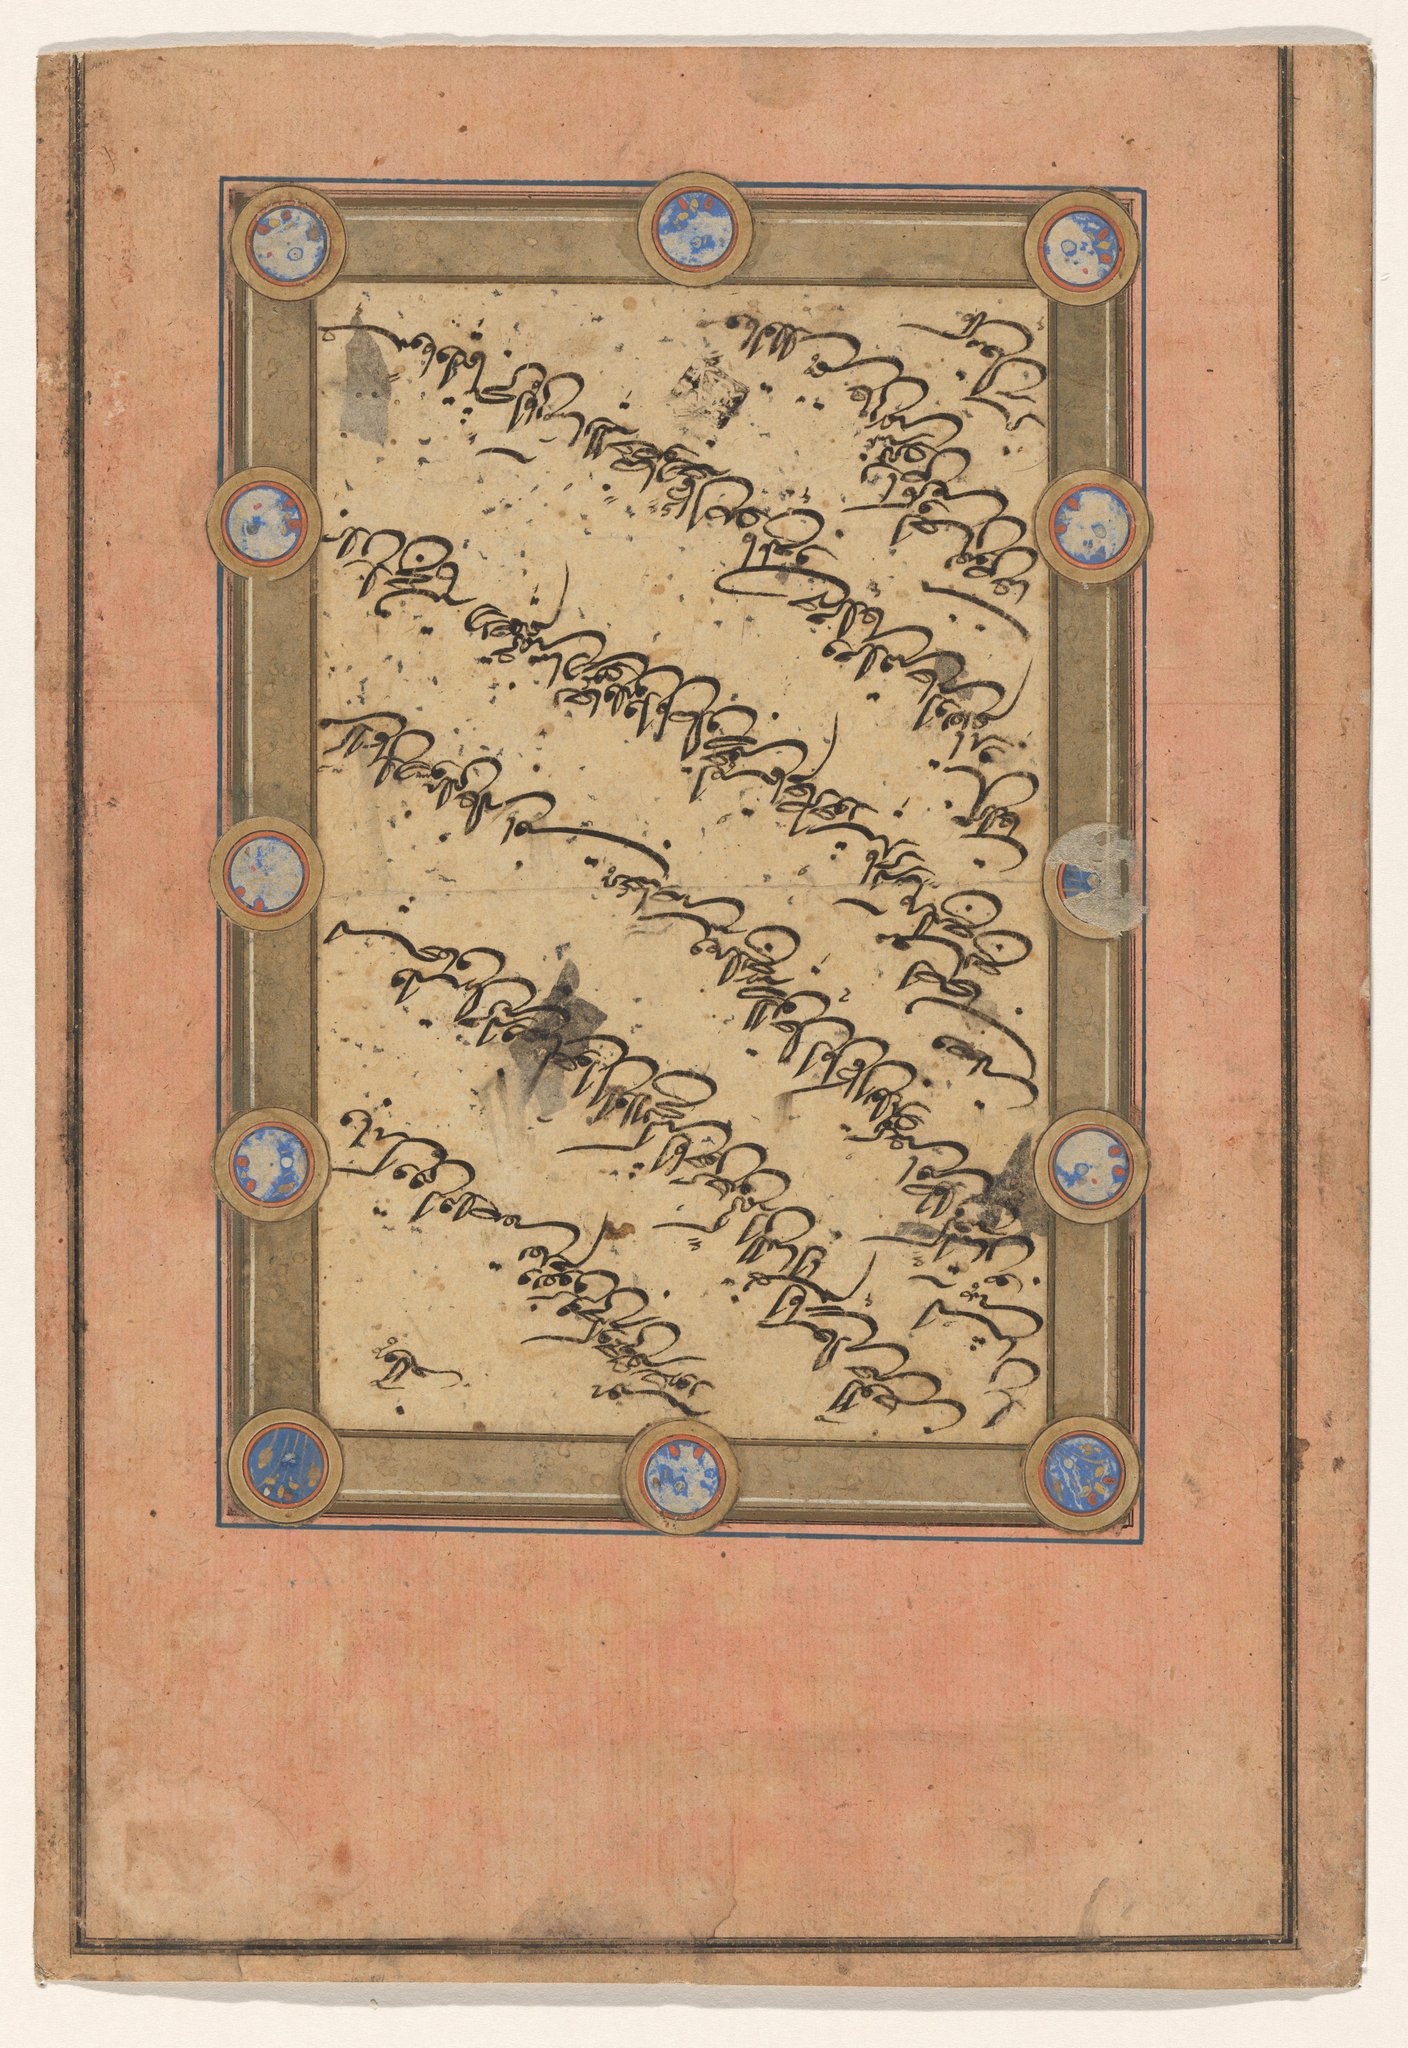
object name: persian miniature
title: Kalligrafische tekst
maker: Anonymous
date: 1700-1899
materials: paper, watercolor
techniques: brush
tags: calligraphy